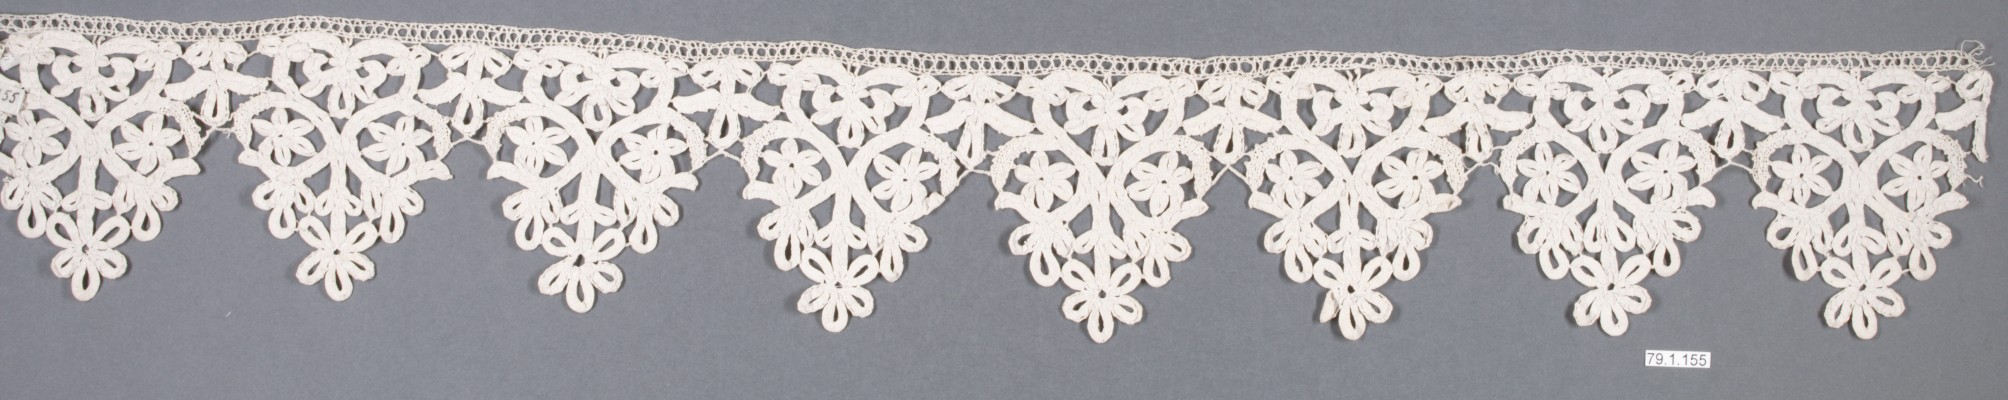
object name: strip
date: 1601-1700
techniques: lace